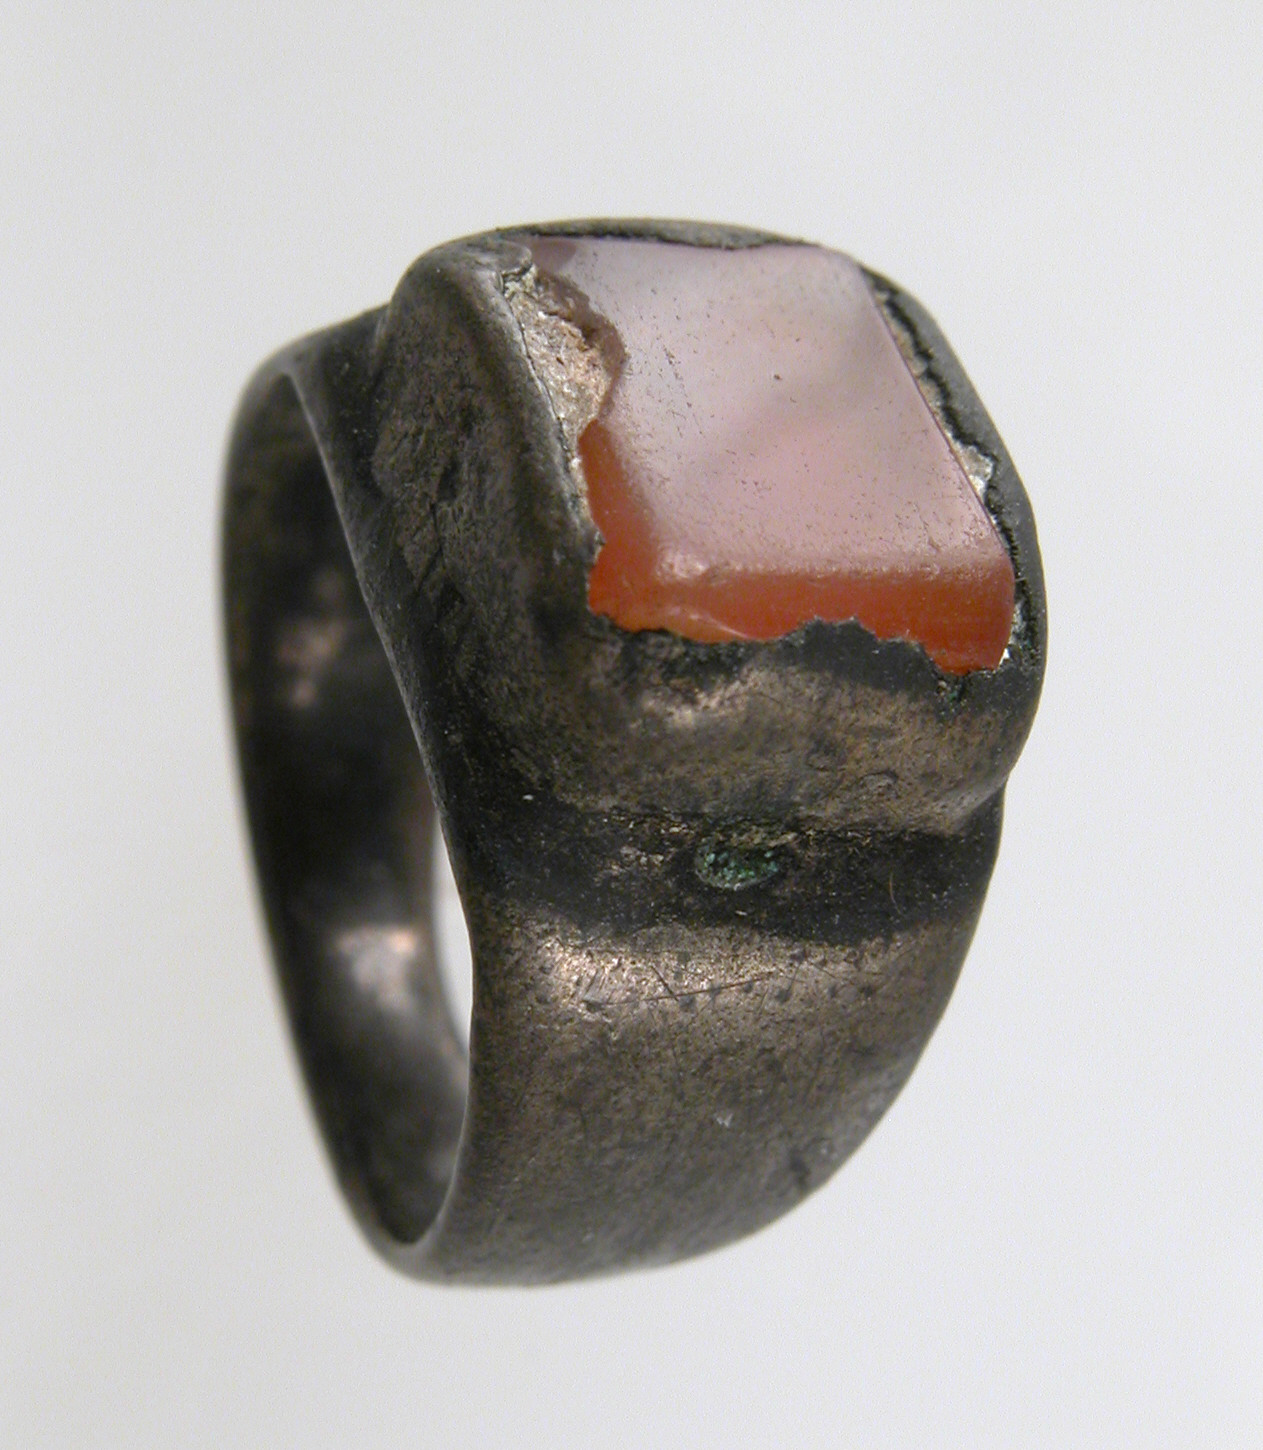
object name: ring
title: Finger Ring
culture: frankish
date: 601-700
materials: onyx, silver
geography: northern france